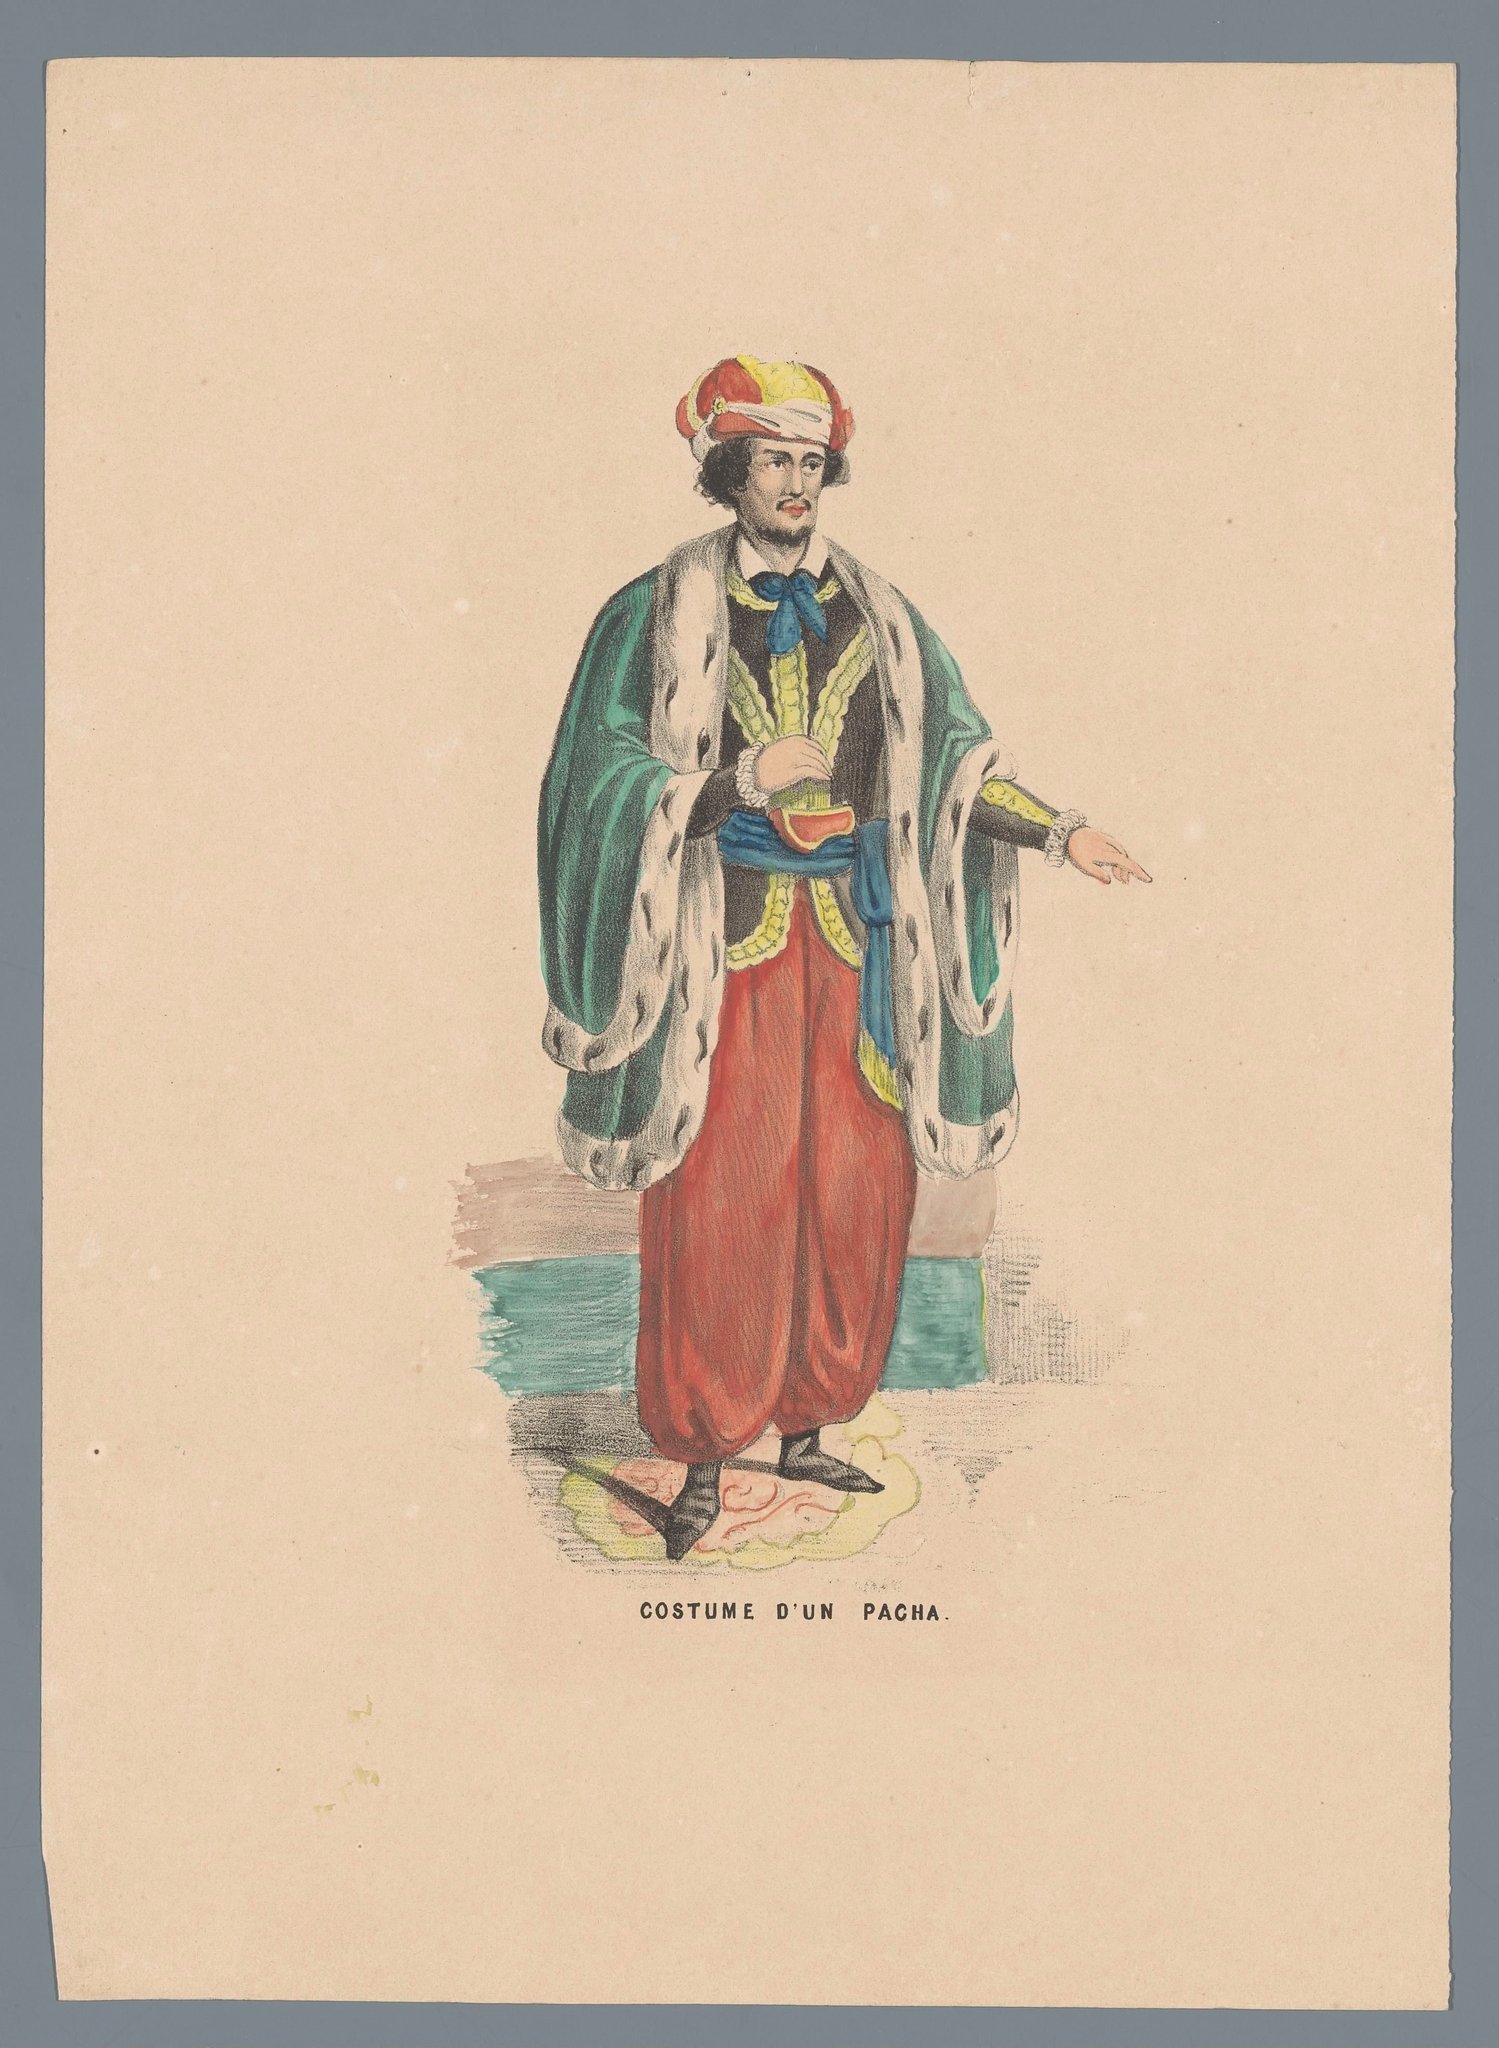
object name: costume print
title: Costume d'un Pacha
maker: elias spanier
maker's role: print maker, printer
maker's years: 1821-1863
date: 1840-1850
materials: paper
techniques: hand coloring, lithograph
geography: the hague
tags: historical costume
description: Man in kledingdracht als een Ottomaanse pasja. Voorstelling toegevoegd aan het plaatwerk over het gekostumeerd bal gehouden op het paleis van de prins van Oranje (de latere koning Willem III) in Den Haag op 26 februari 1845.